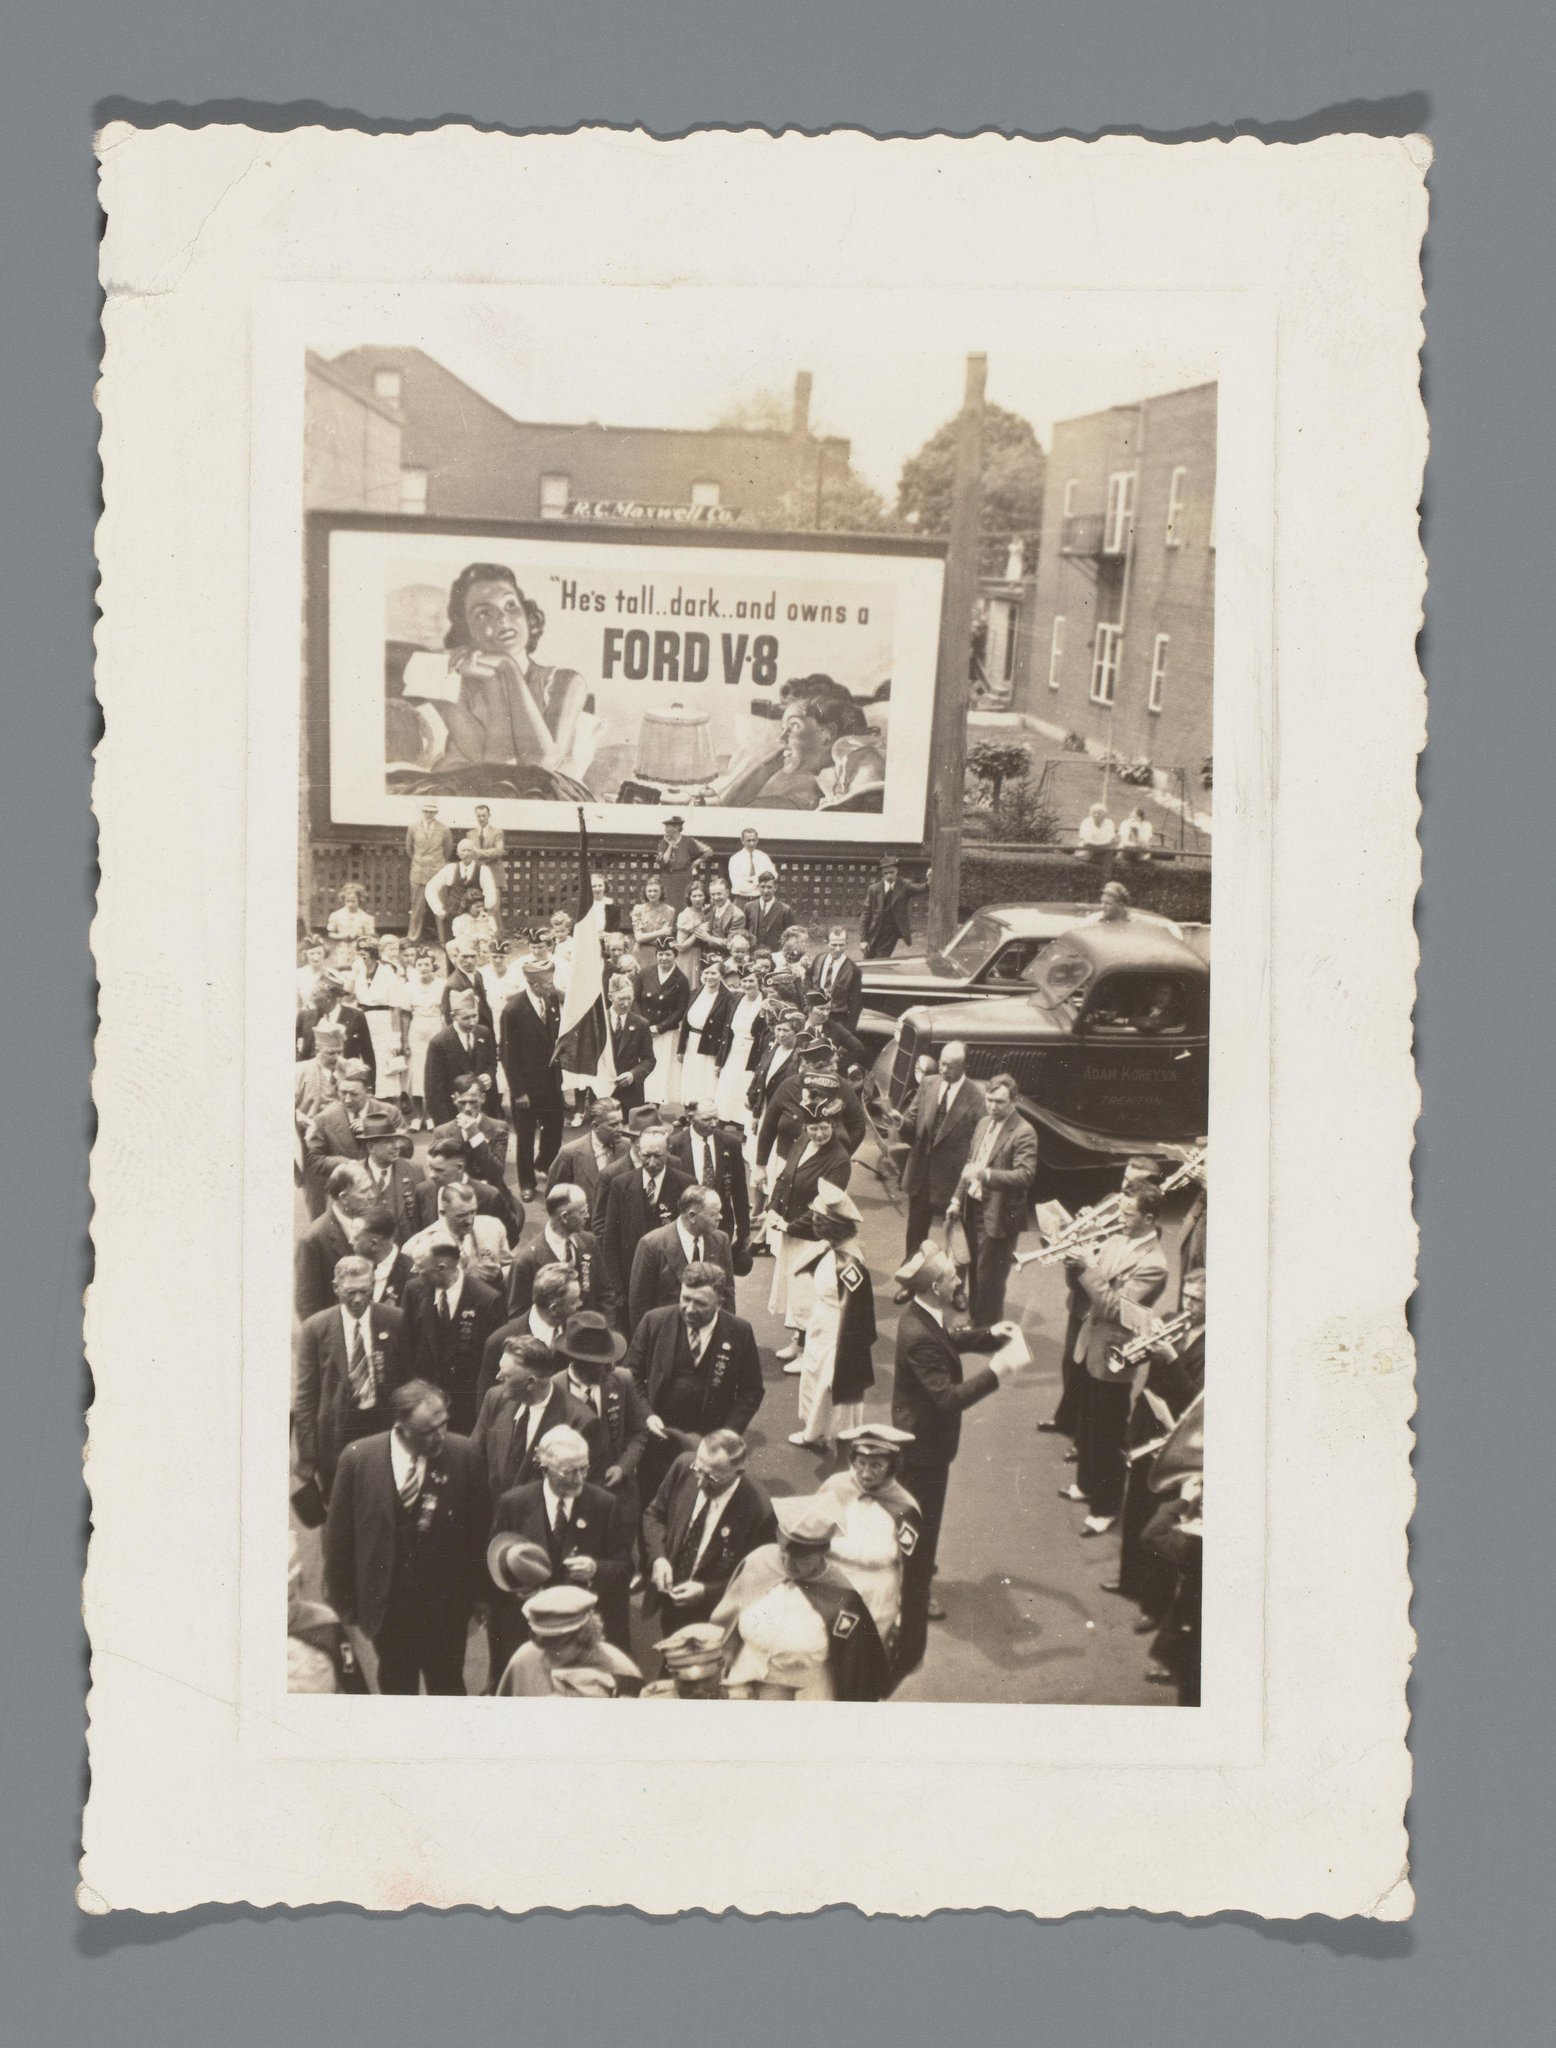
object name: photograph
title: He's tall ..dark.. and owns a Ford V8. Optreden van een muziekband op straat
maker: Anonymous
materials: photographic support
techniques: gelatin silver print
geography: united states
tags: united states of america